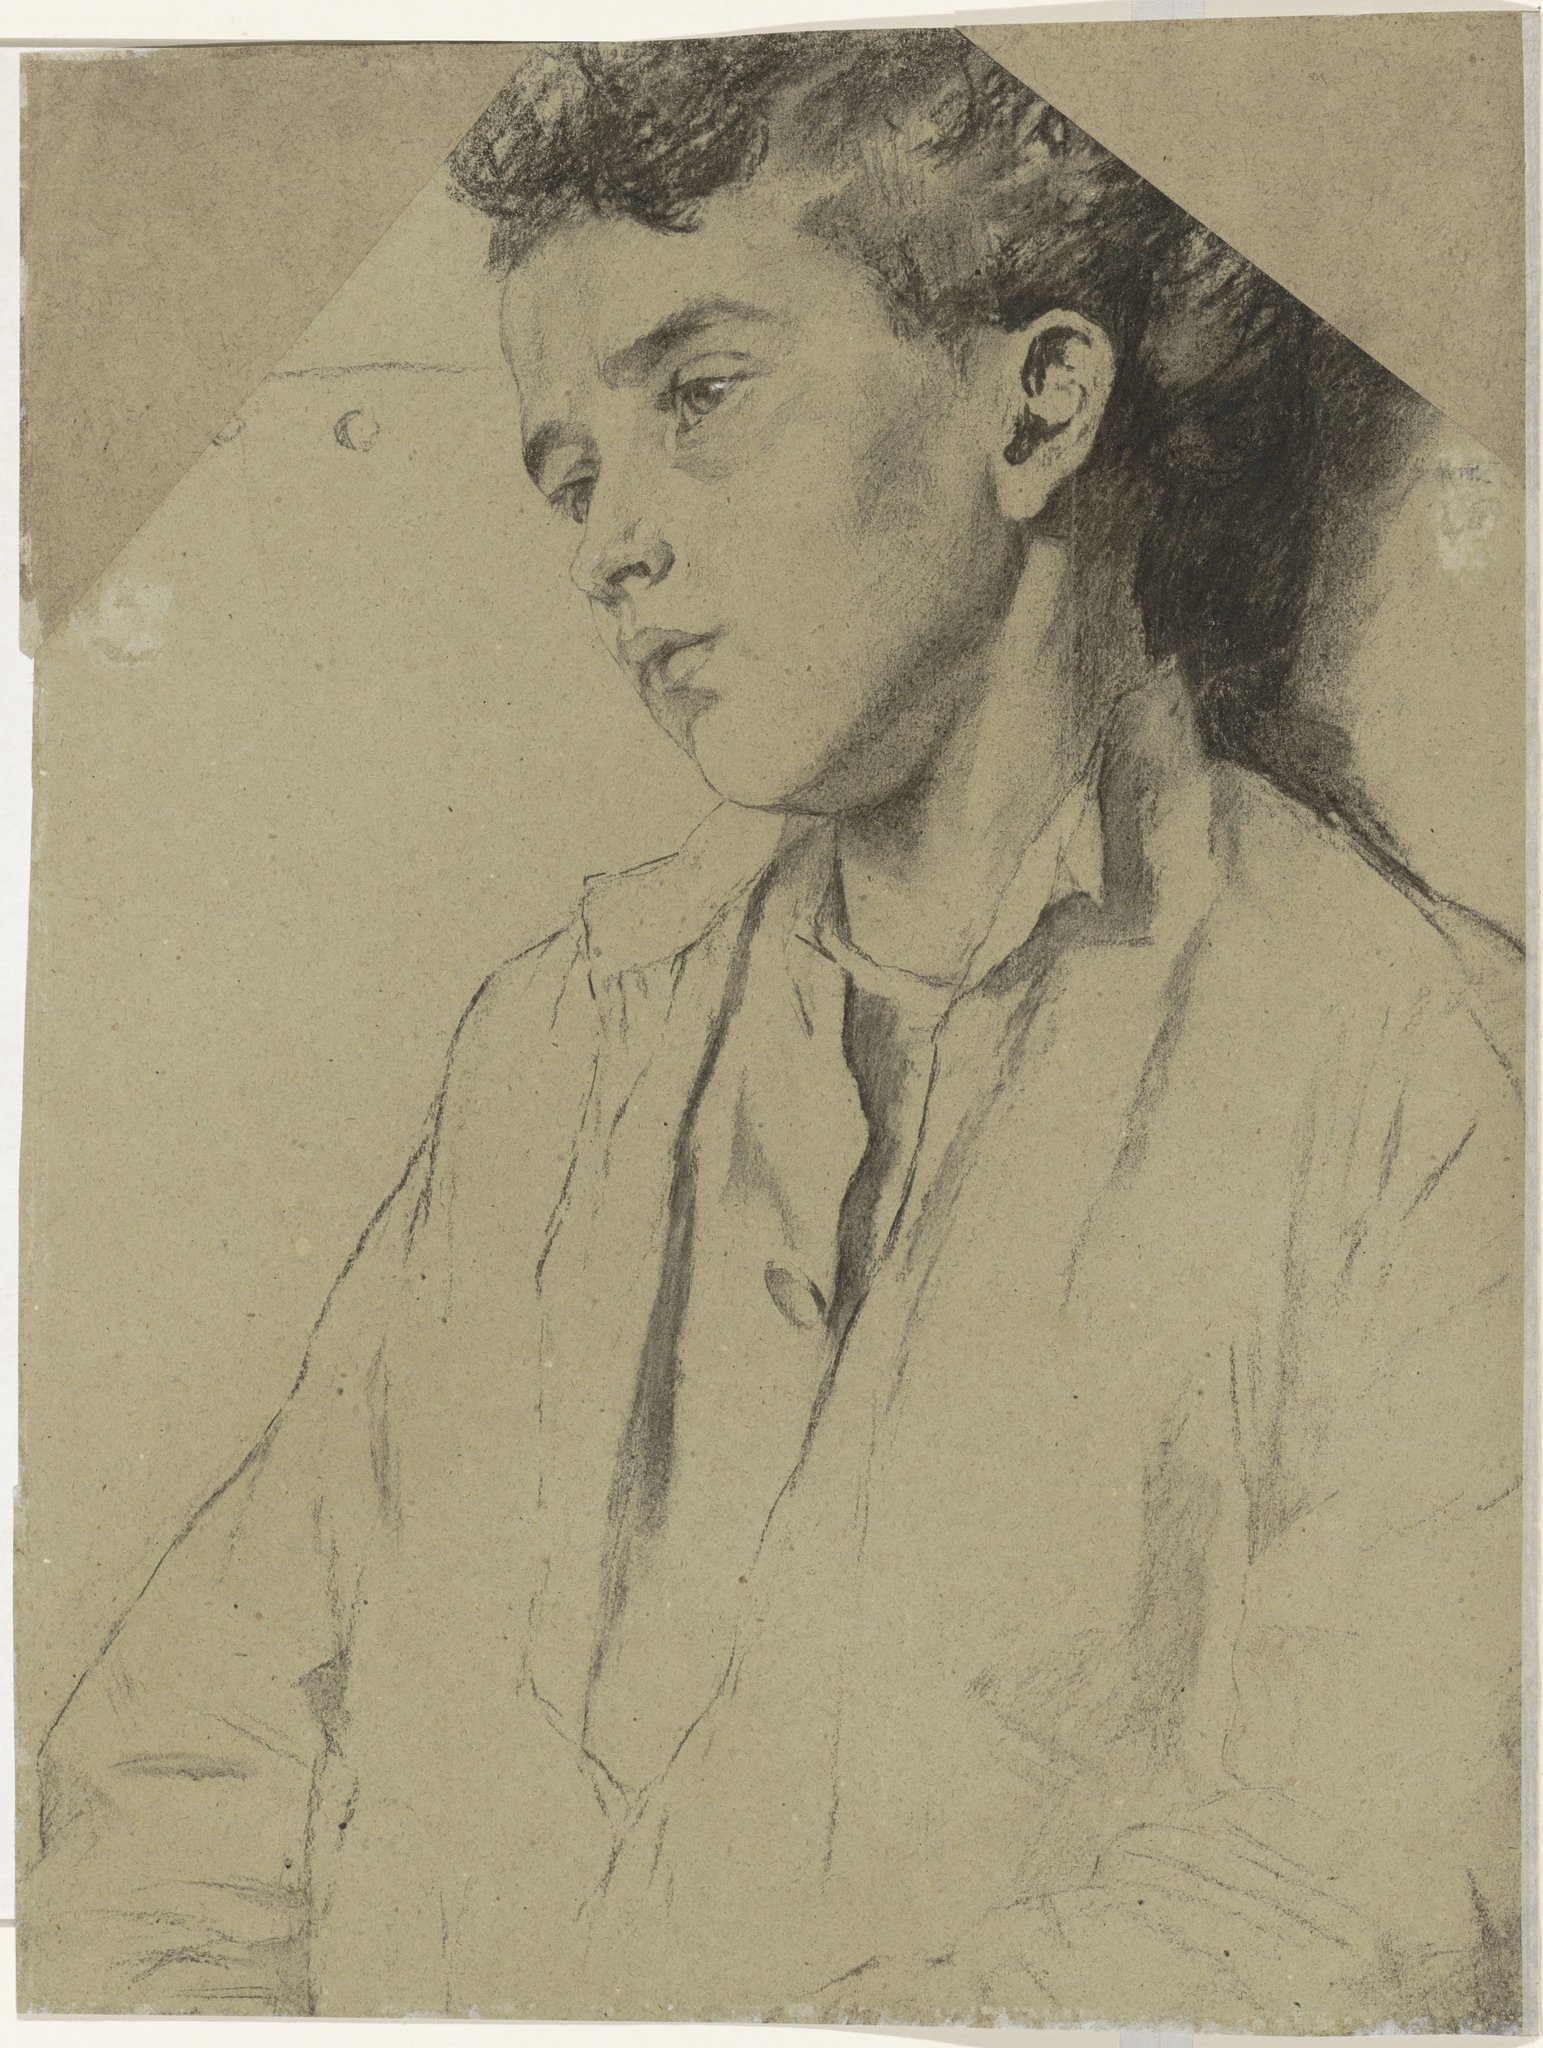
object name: drawing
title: Portret van een jongen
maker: thérèse schwartze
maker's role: draughtsman, painter, print maker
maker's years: 1851-1918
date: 1861-1918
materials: chalk, charcoal, paper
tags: anonymous historical person portrayed alone